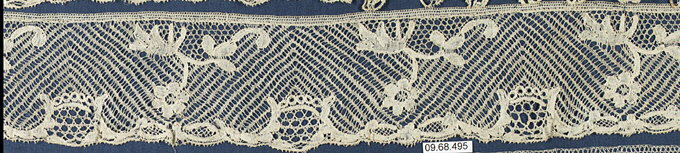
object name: fragment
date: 1801-1900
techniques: lace